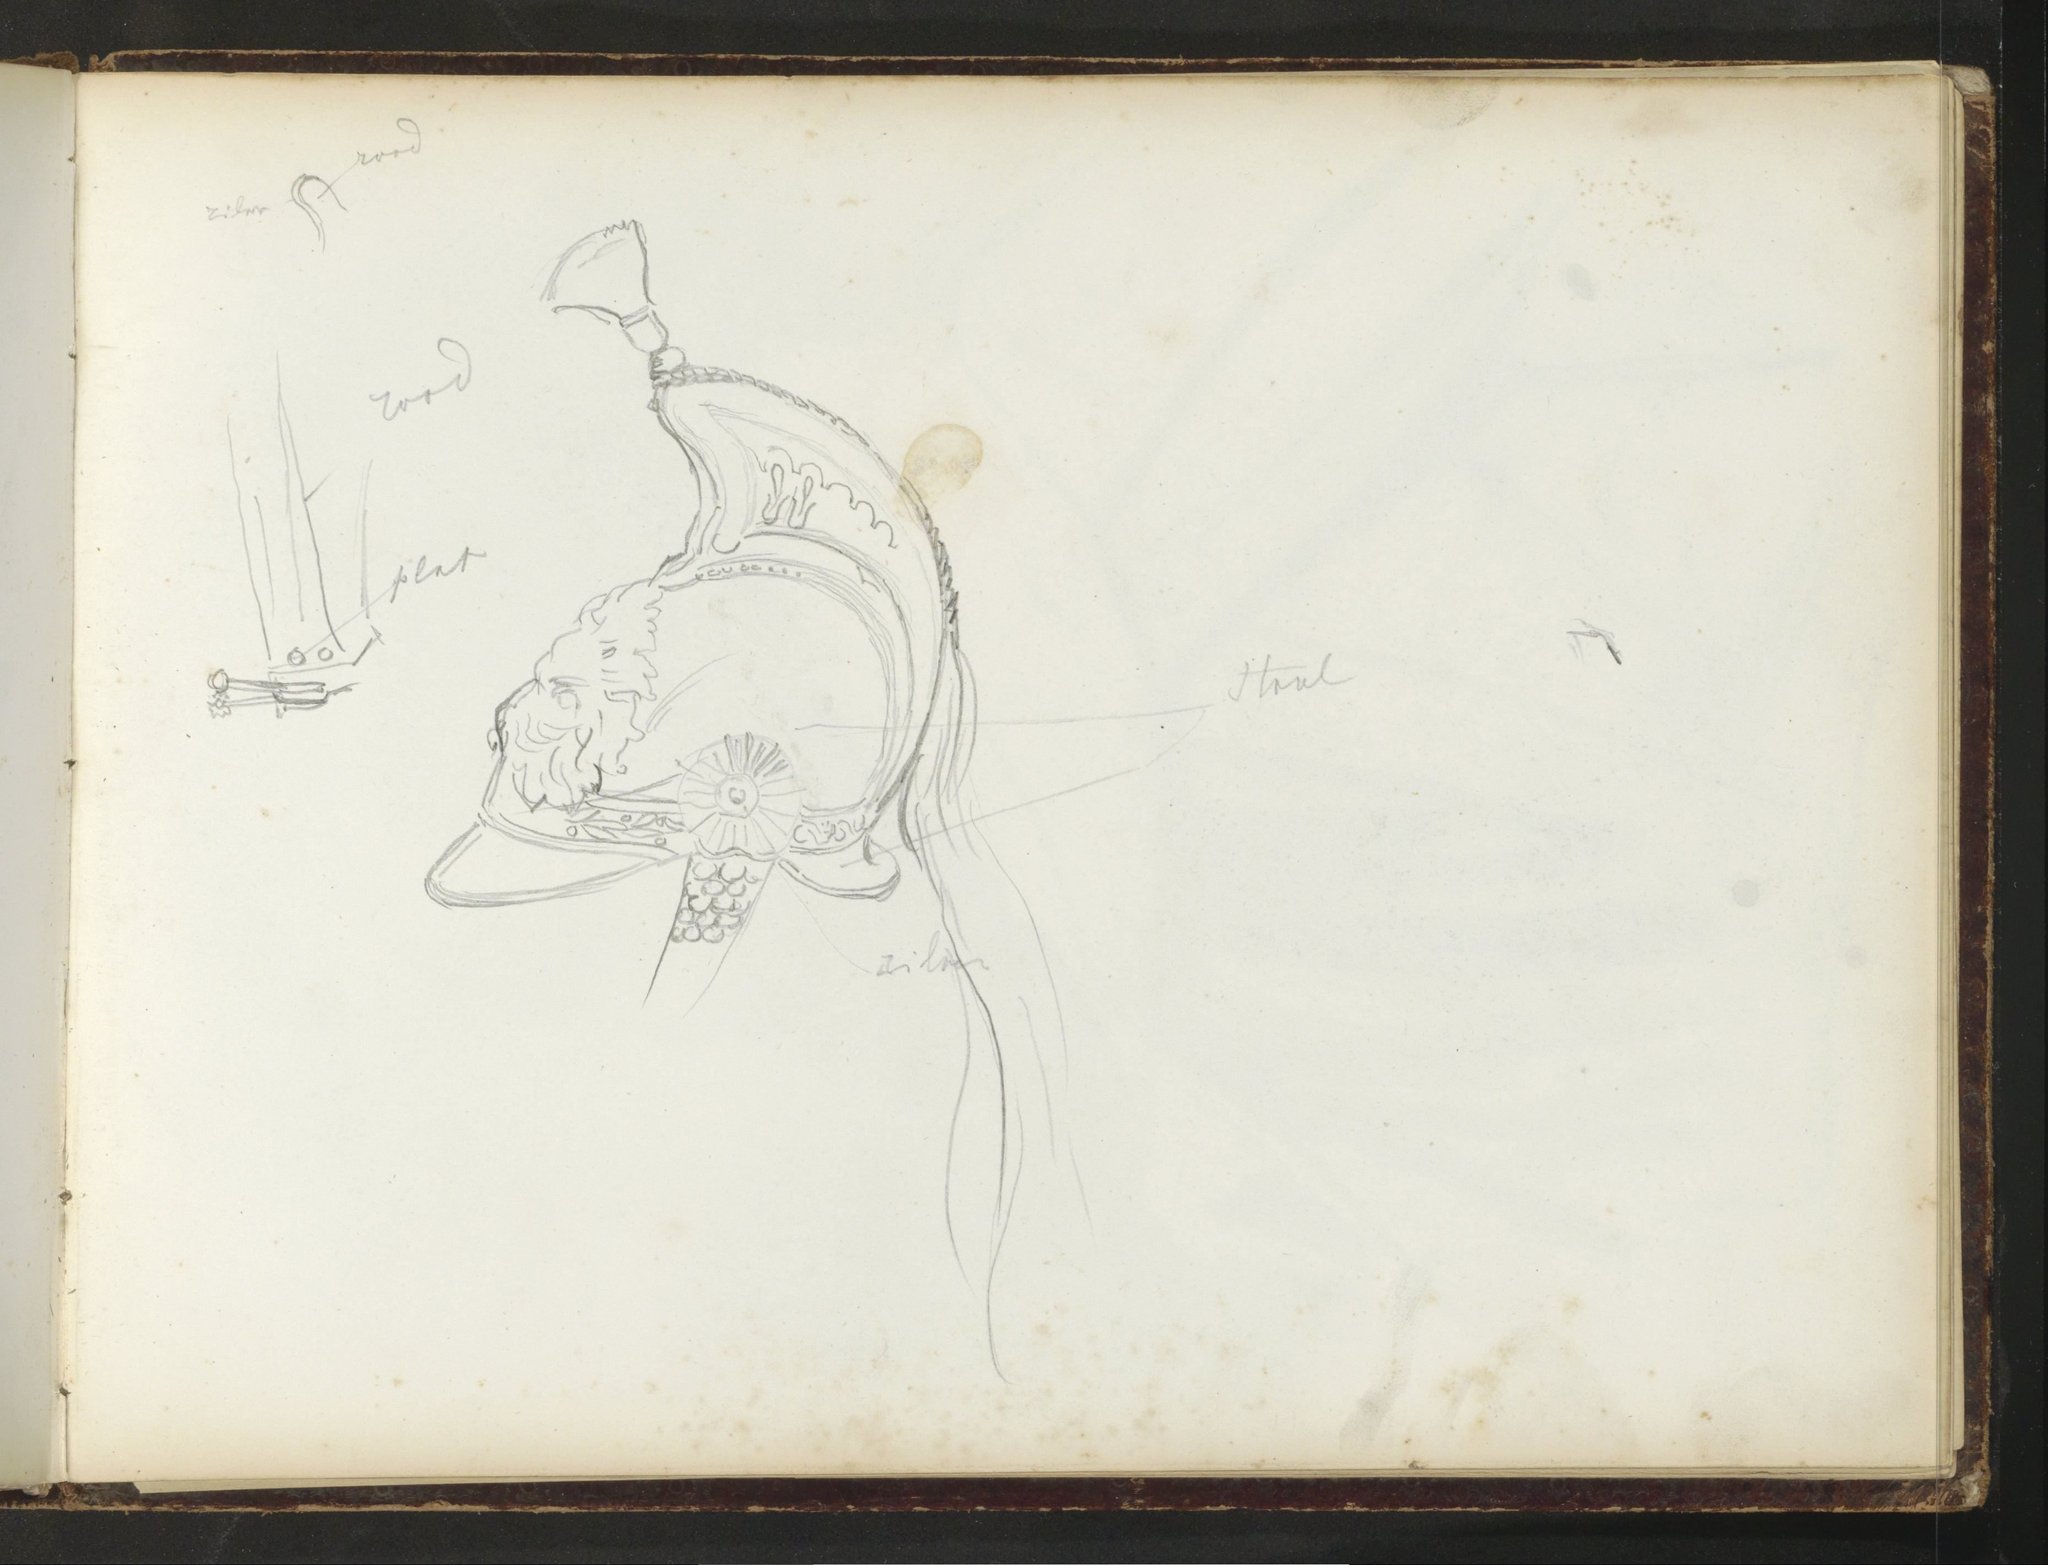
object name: sketchbook leaf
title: Stalen helm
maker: reinier craeyvanger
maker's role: draughtsman, print maker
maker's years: 1812-1880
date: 1822-1880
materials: paper, pencil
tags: helmet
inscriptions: kleurnotitie, handgeschreven in potlood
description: Blad 38 recto uit een schetsboek met 45 bladen.